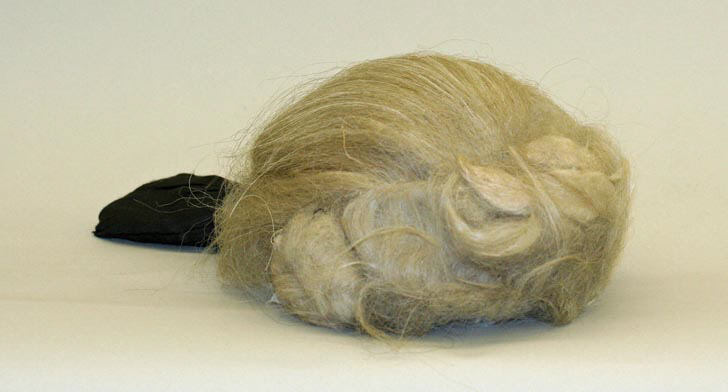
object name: wig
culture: italian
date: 1851-1900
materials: hair